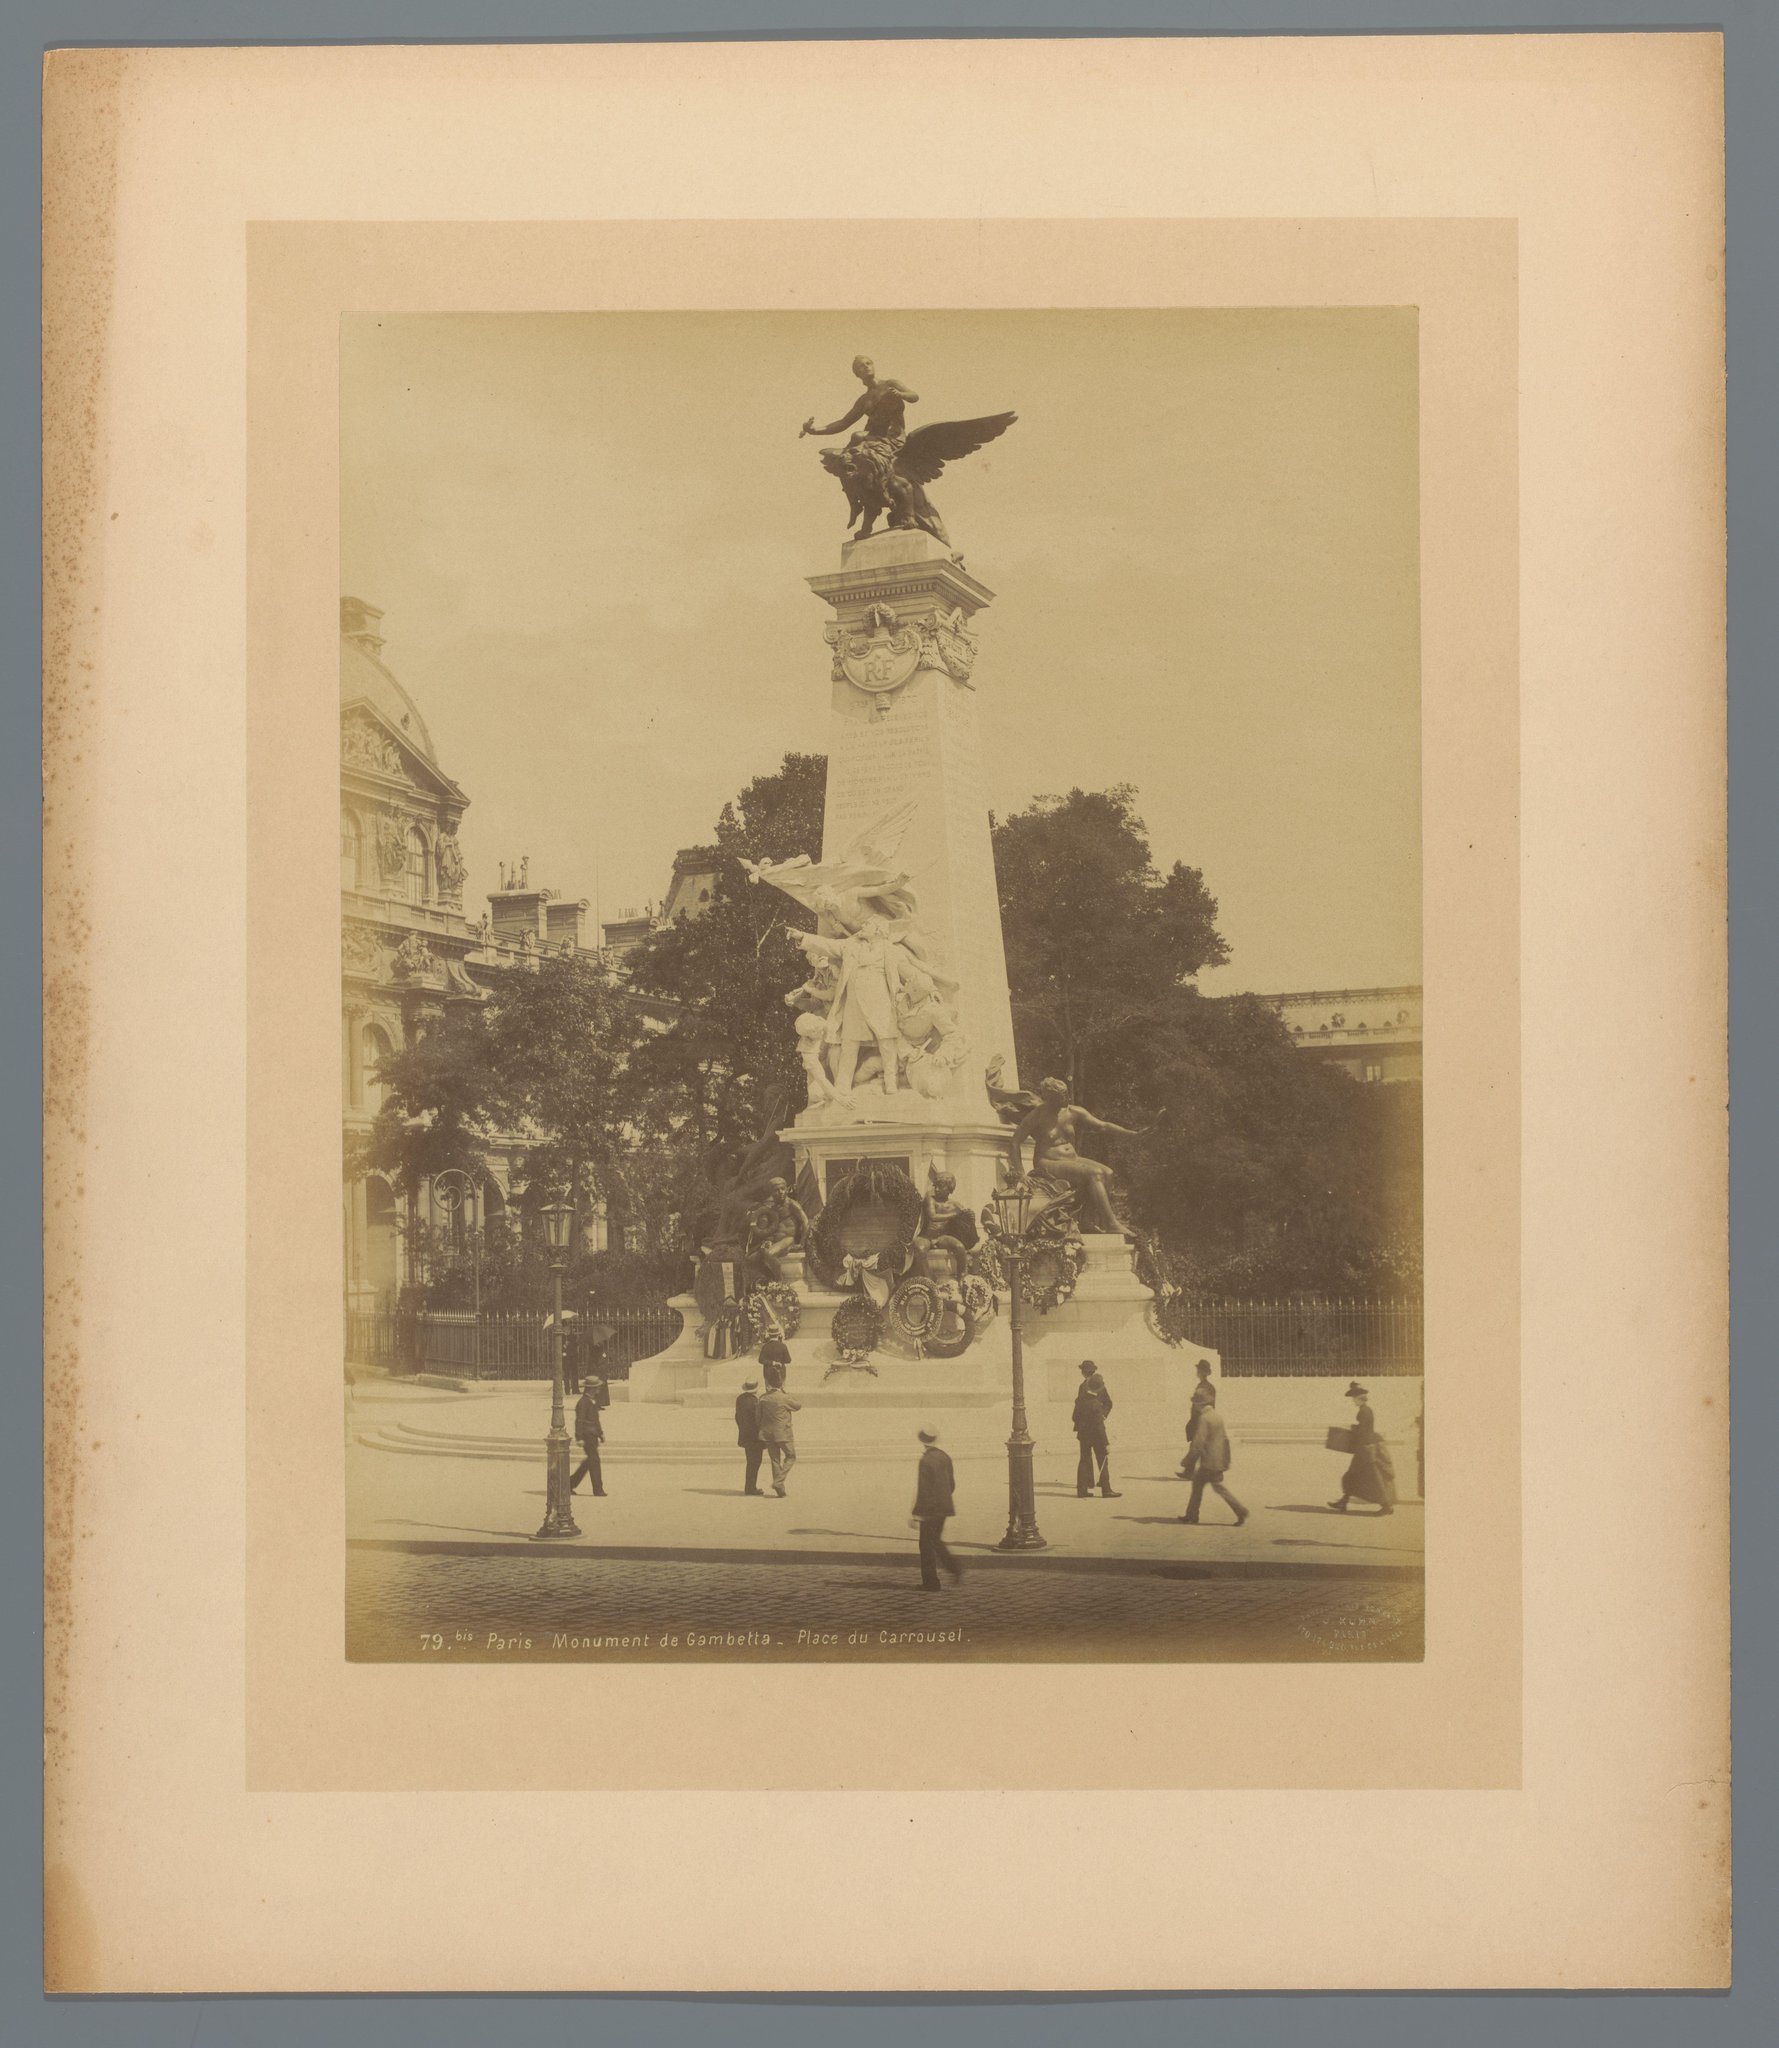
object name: photograph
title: "Monument de Gambetta, Place du Carrousel", Parijs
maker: j. kühn (uitgever)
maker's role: publisher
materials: cardboard, paper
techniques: albumen print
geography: paris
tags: paris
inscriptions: check stamp: ‘Photographic [?] Company//J.KUHN//PARIS//220 170174 RUE DE RIVOLI’, inscription: ‘79. bis Paris Monument de Gambetta - Place du Carrousel.’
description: Piramidevormig monument met een groep bronzen beelden, inauguratie vond plaats op 14 juli 1887. Pace du Caroussel, Parijs, Frankrijk.